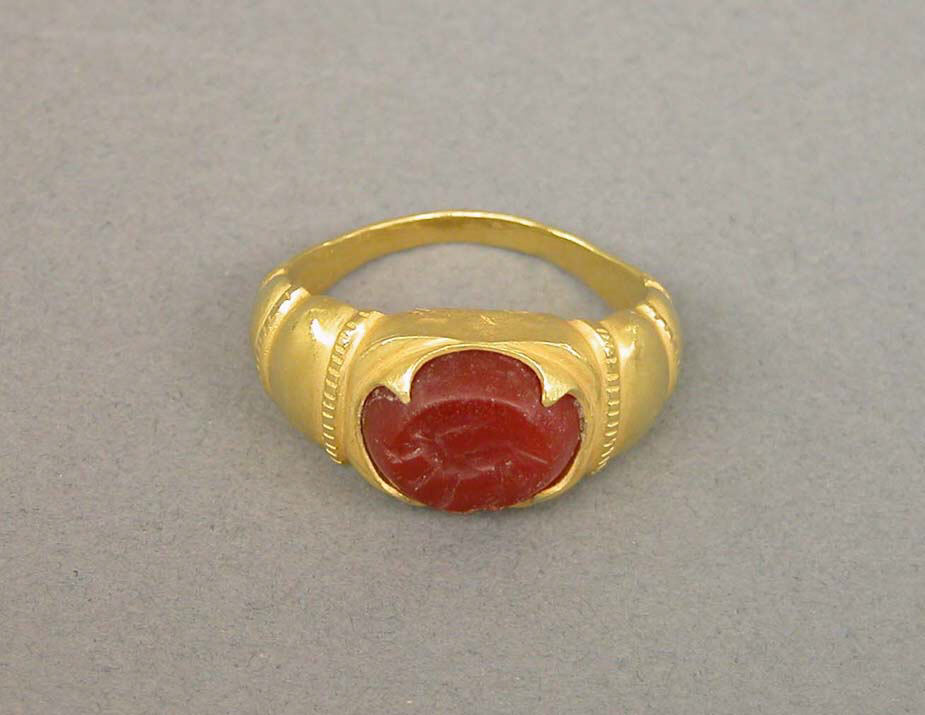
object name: ring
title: Ring with Ridged Segments and Inset Red Stone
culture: indonesian, javanese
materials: gold, stone